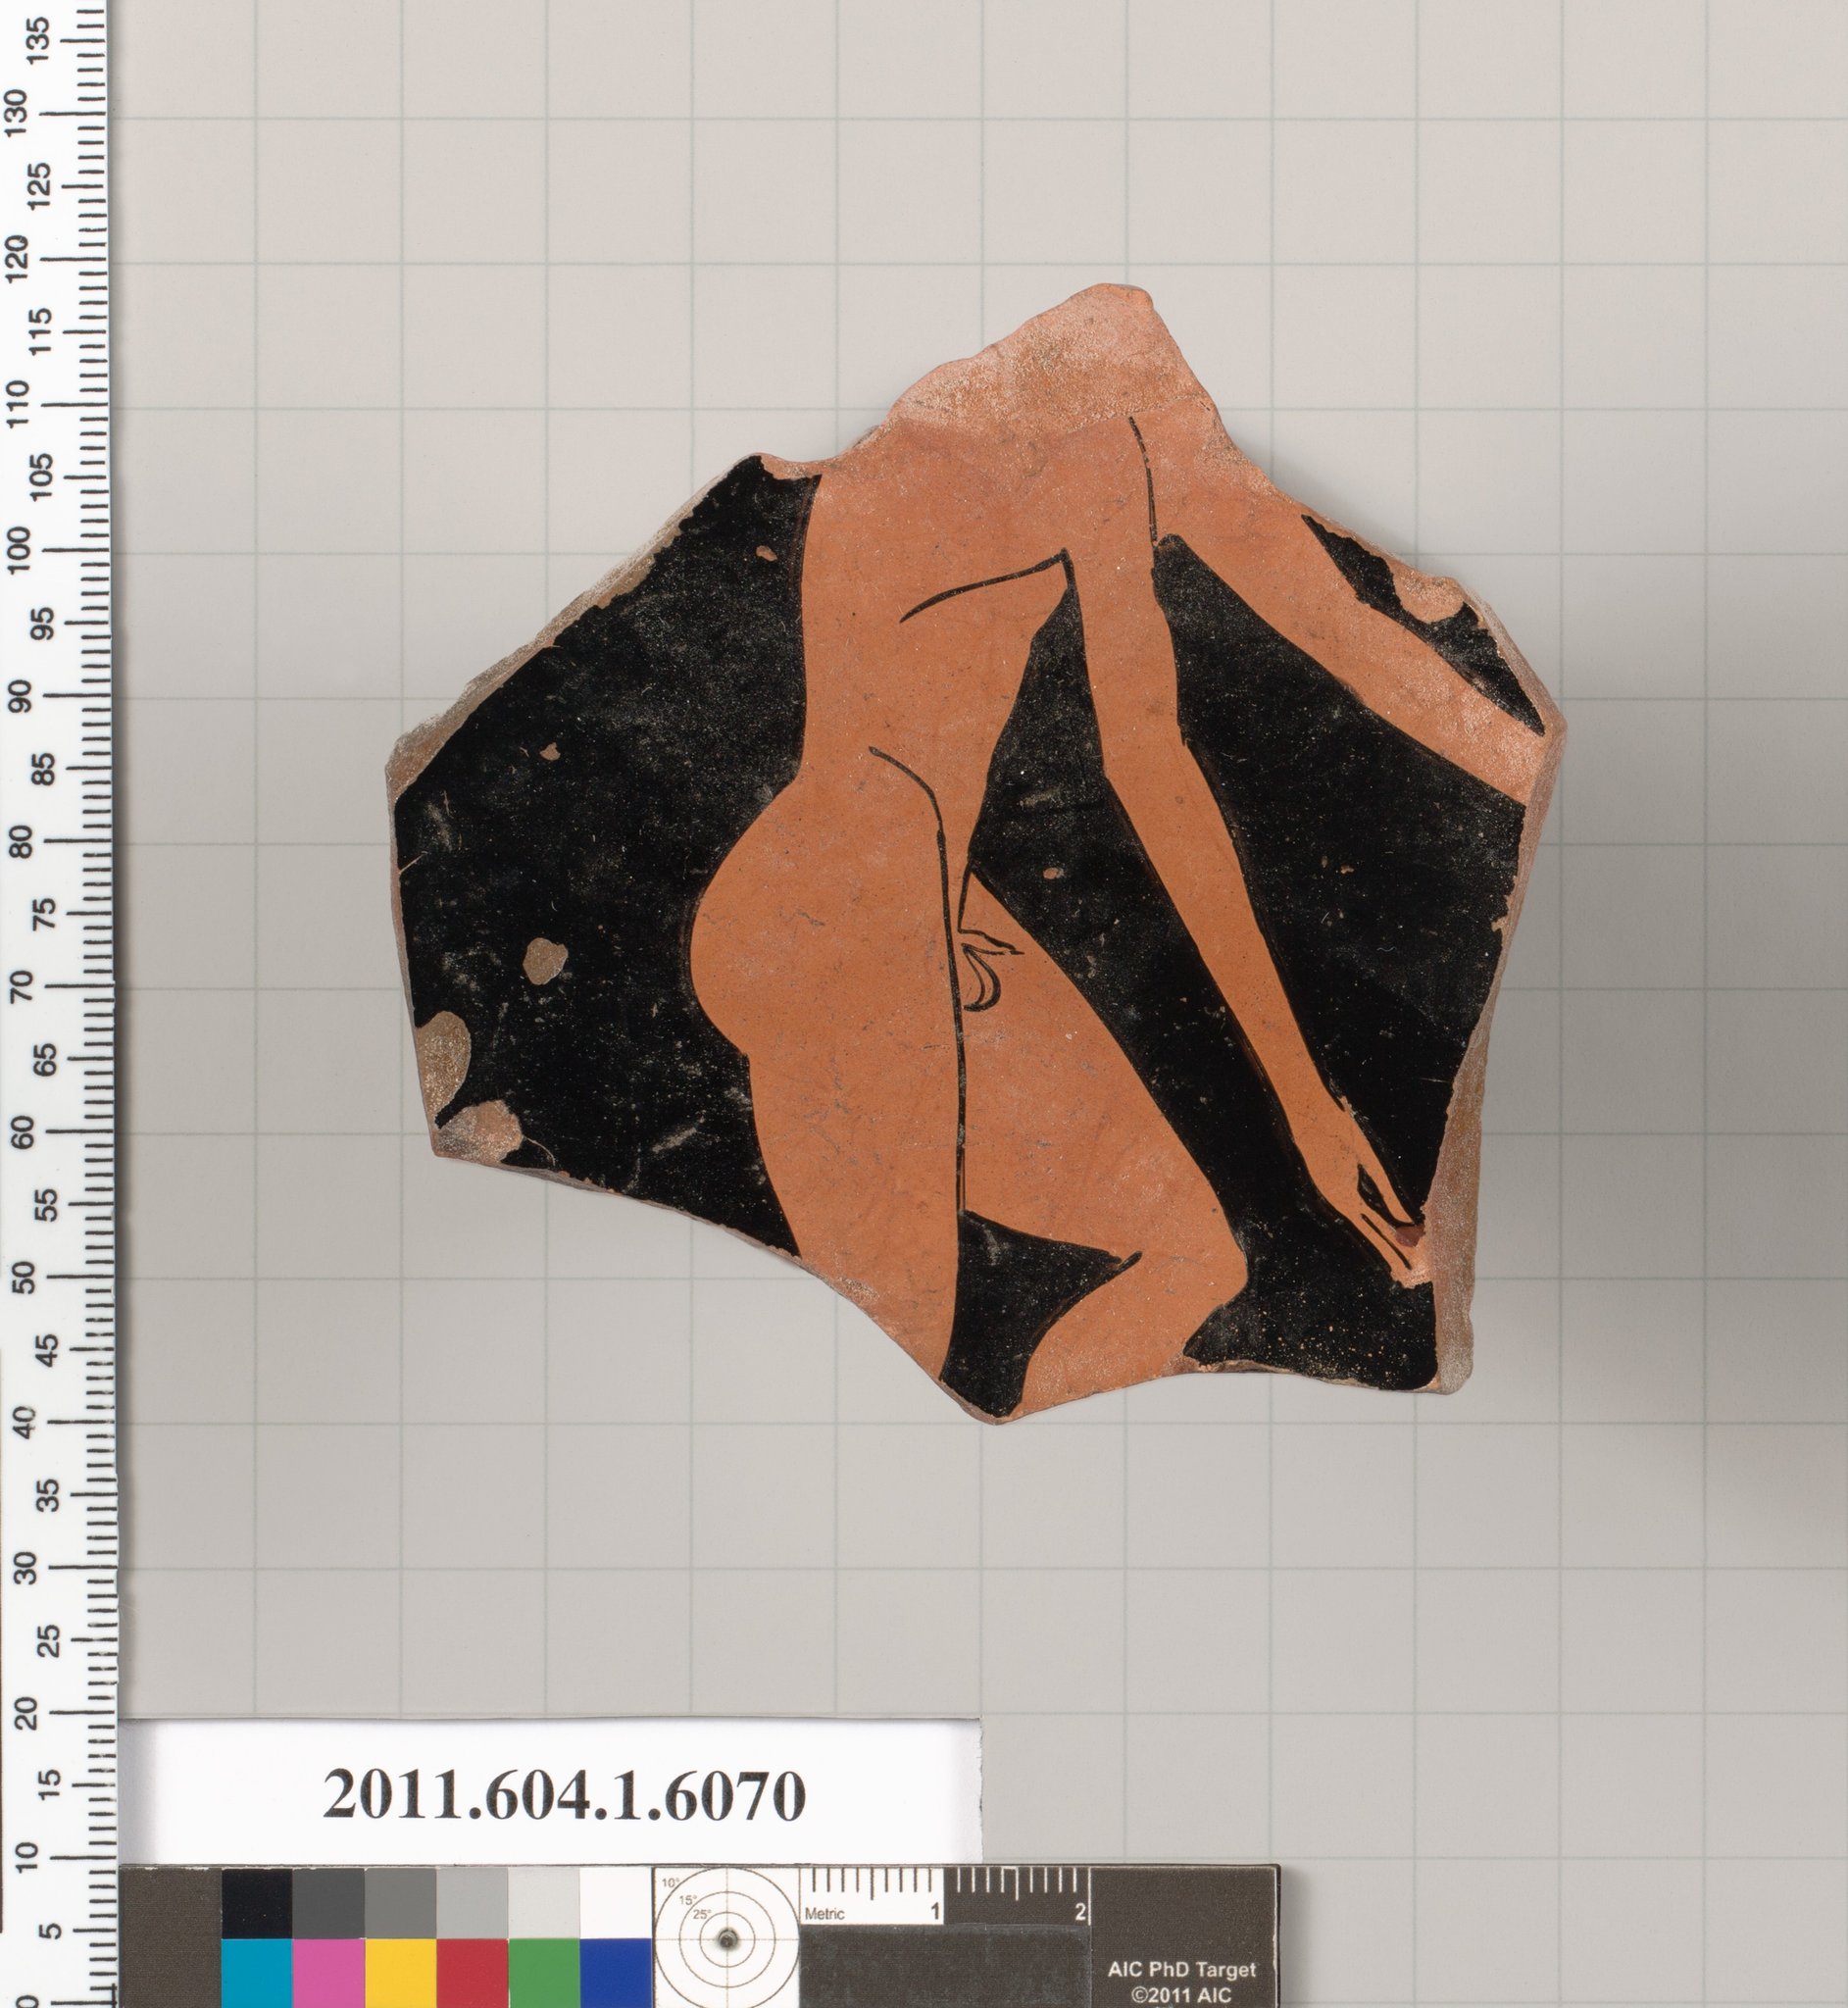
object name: kylix fragment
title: Terracotta fragment of a kylix (drinking cup)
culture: greek, attic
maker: euergides painter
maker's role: artist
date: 510-500 BCE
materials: terracotta